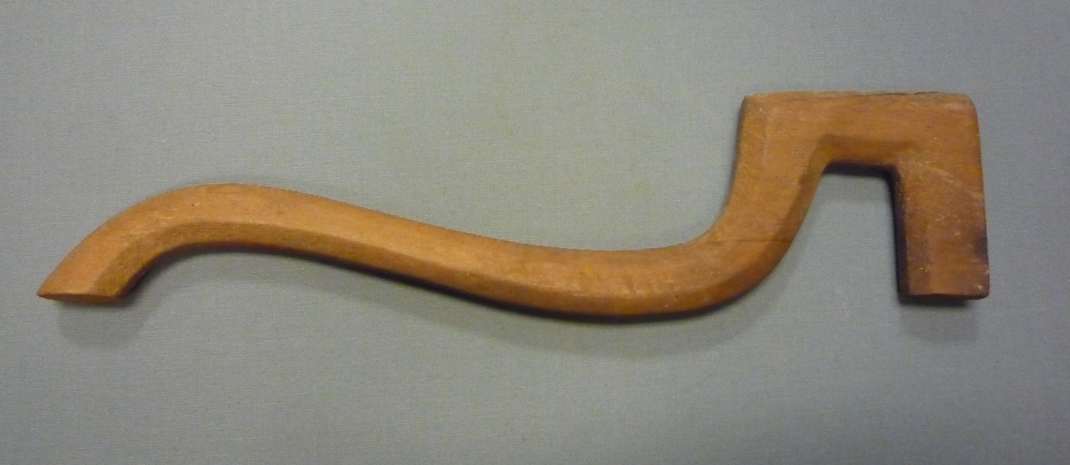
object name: tool, mesekhetyu, hatshepsut foundation deposit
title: Ritual tool for the "Opening of the Mouth" ceremony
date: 1479-1458 BCE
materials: wood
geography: egypt